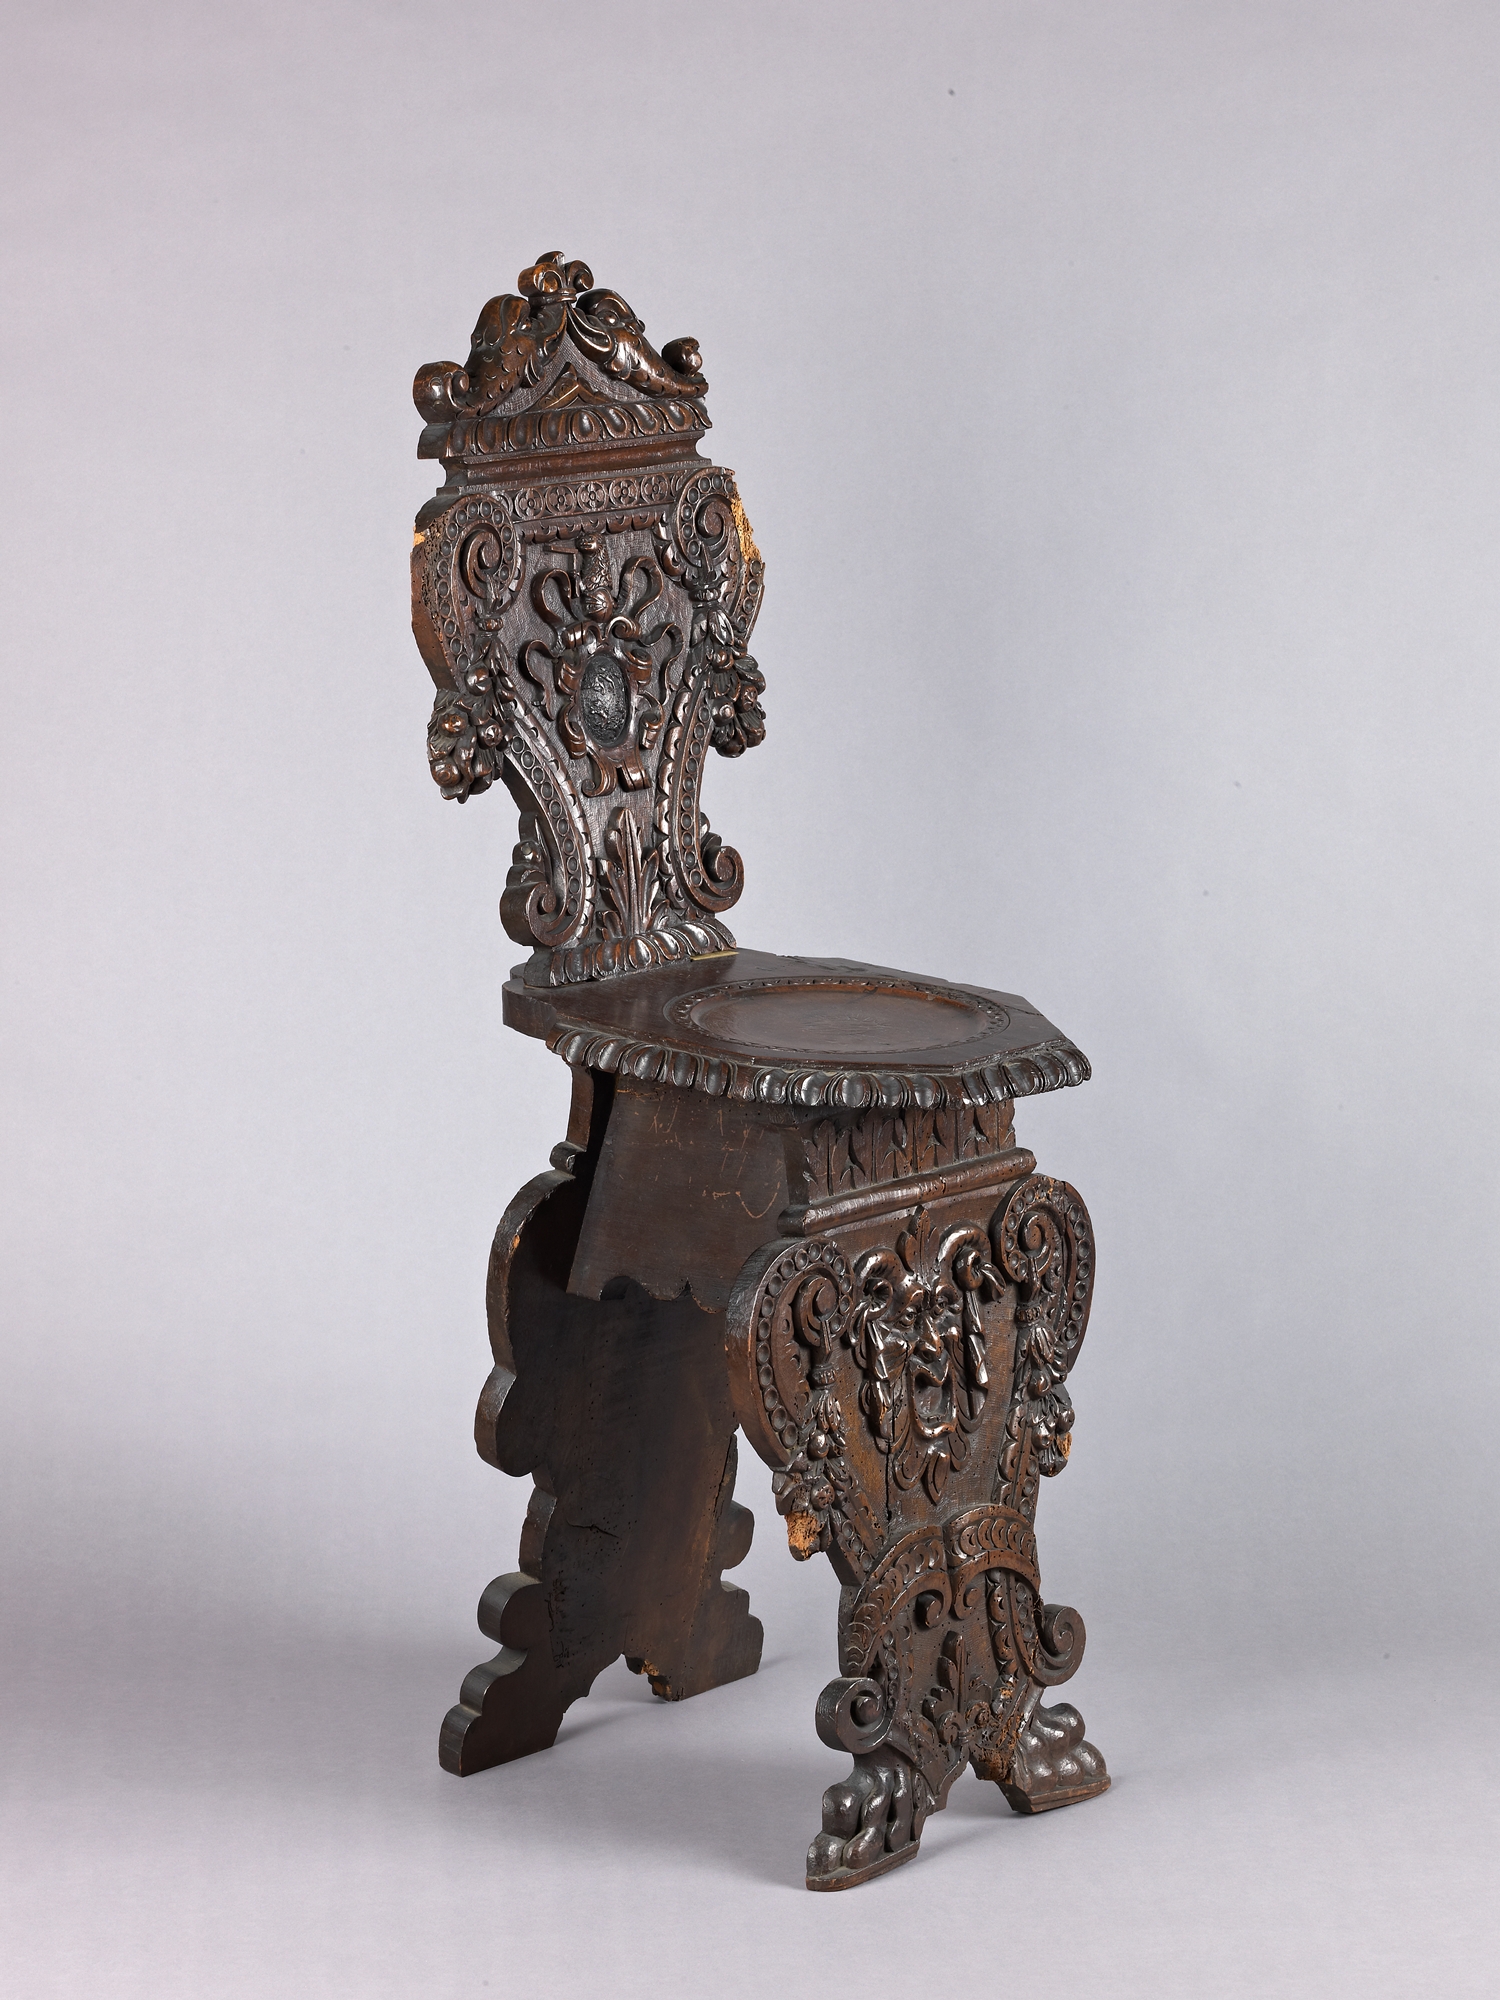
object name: chair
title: Side chair (Sgabello, pair with 1975.1.1989)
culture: italian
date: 1567-1600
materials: wood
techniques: carving